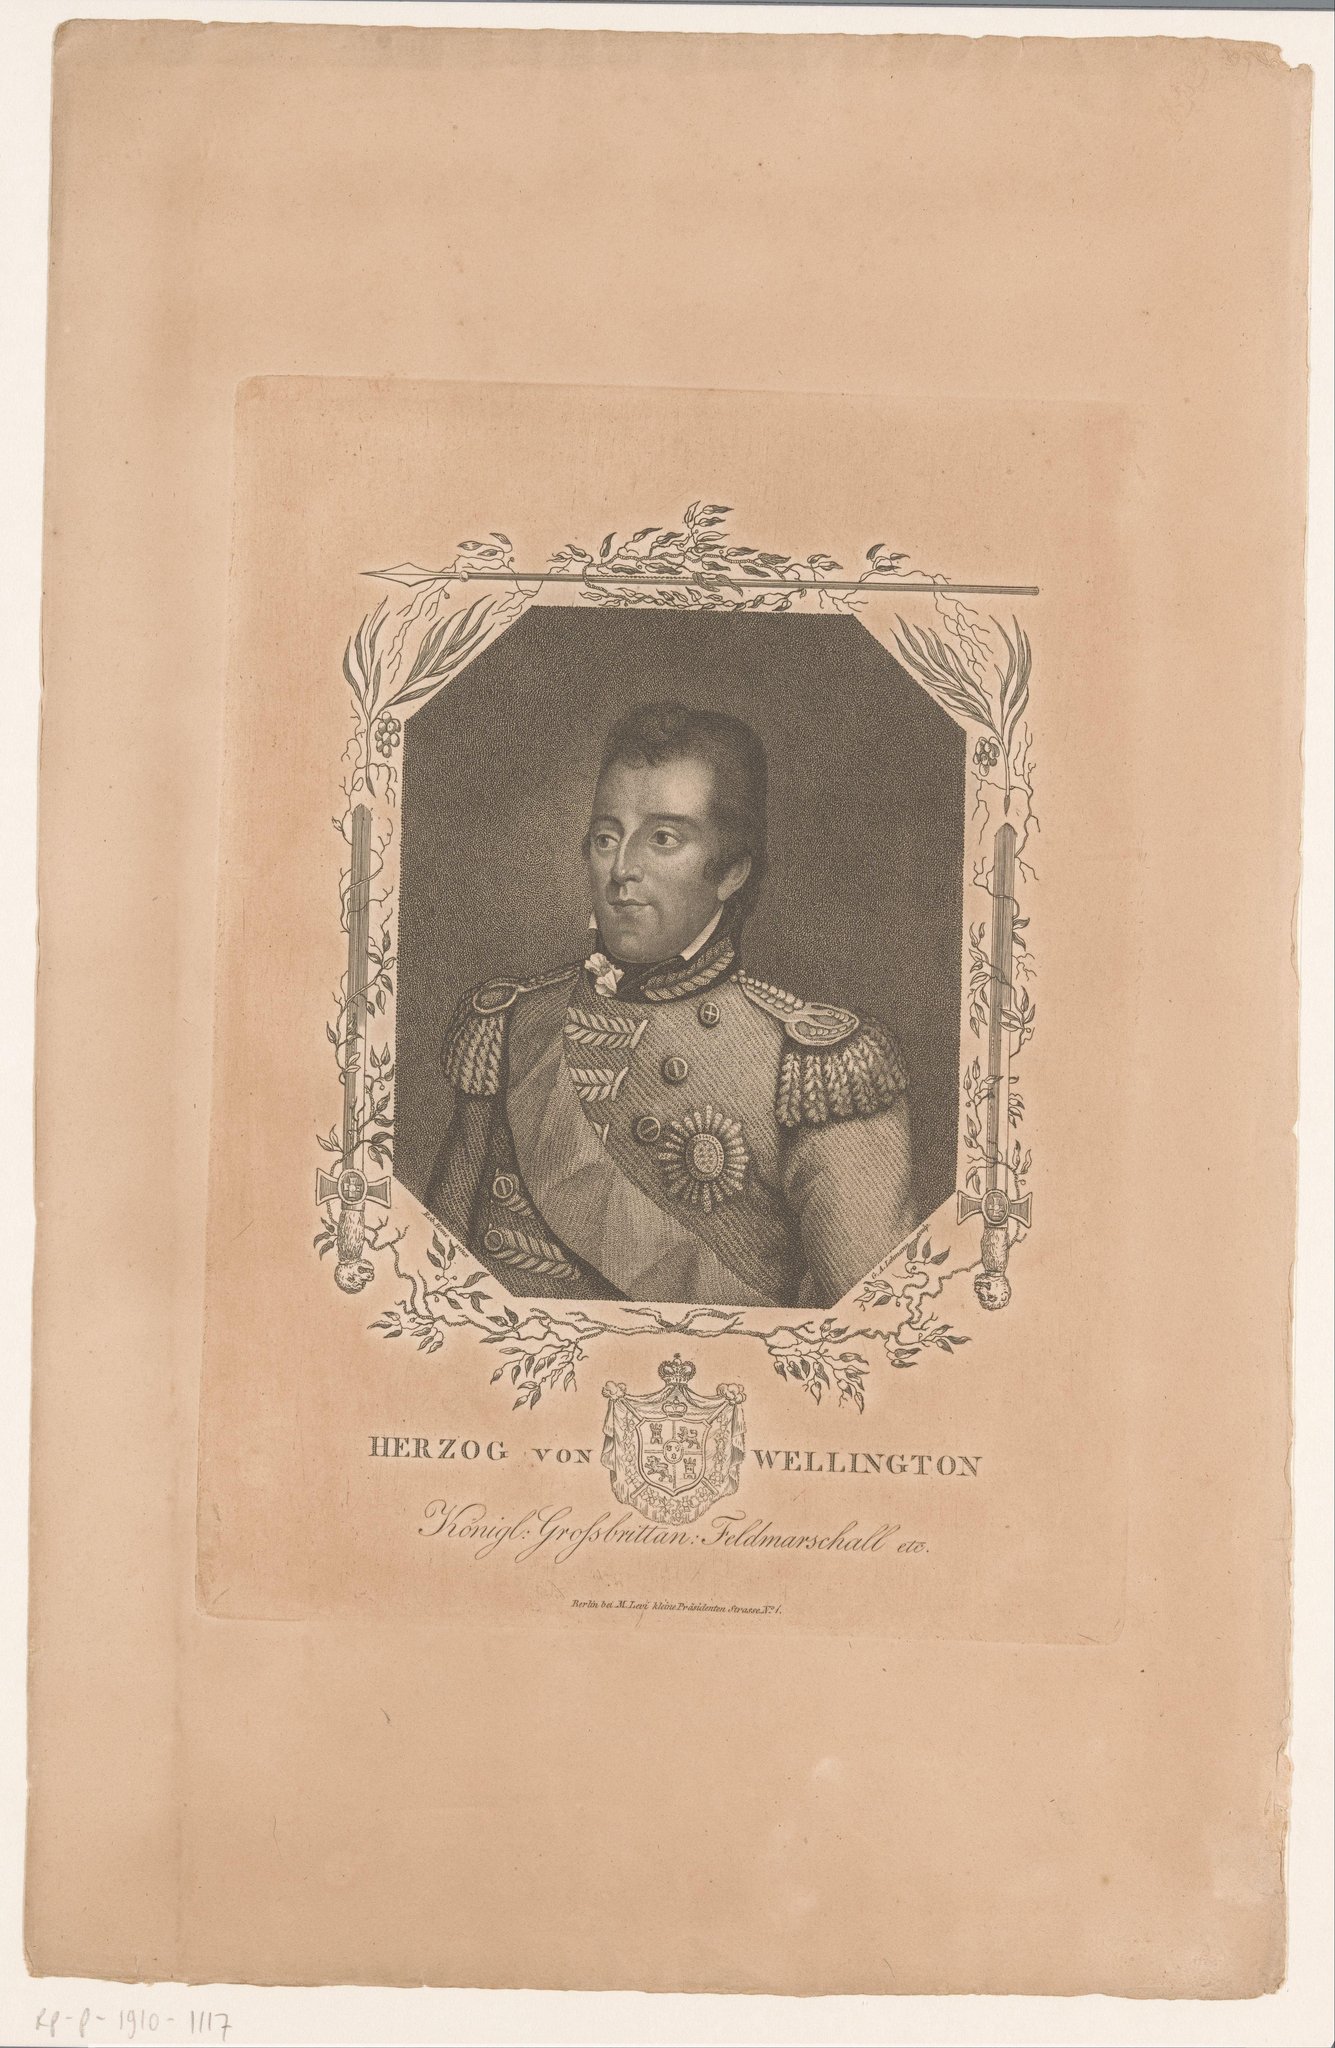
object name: print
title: Portret van Arthur Wellesley of Wellington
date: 1780-1869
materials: paper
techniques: printmaking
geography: berlin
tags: walmer castle, arthur wellesley of wellington, historical persons, armorial bearing, heraldry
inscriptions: collector's mark: Lugt 2228